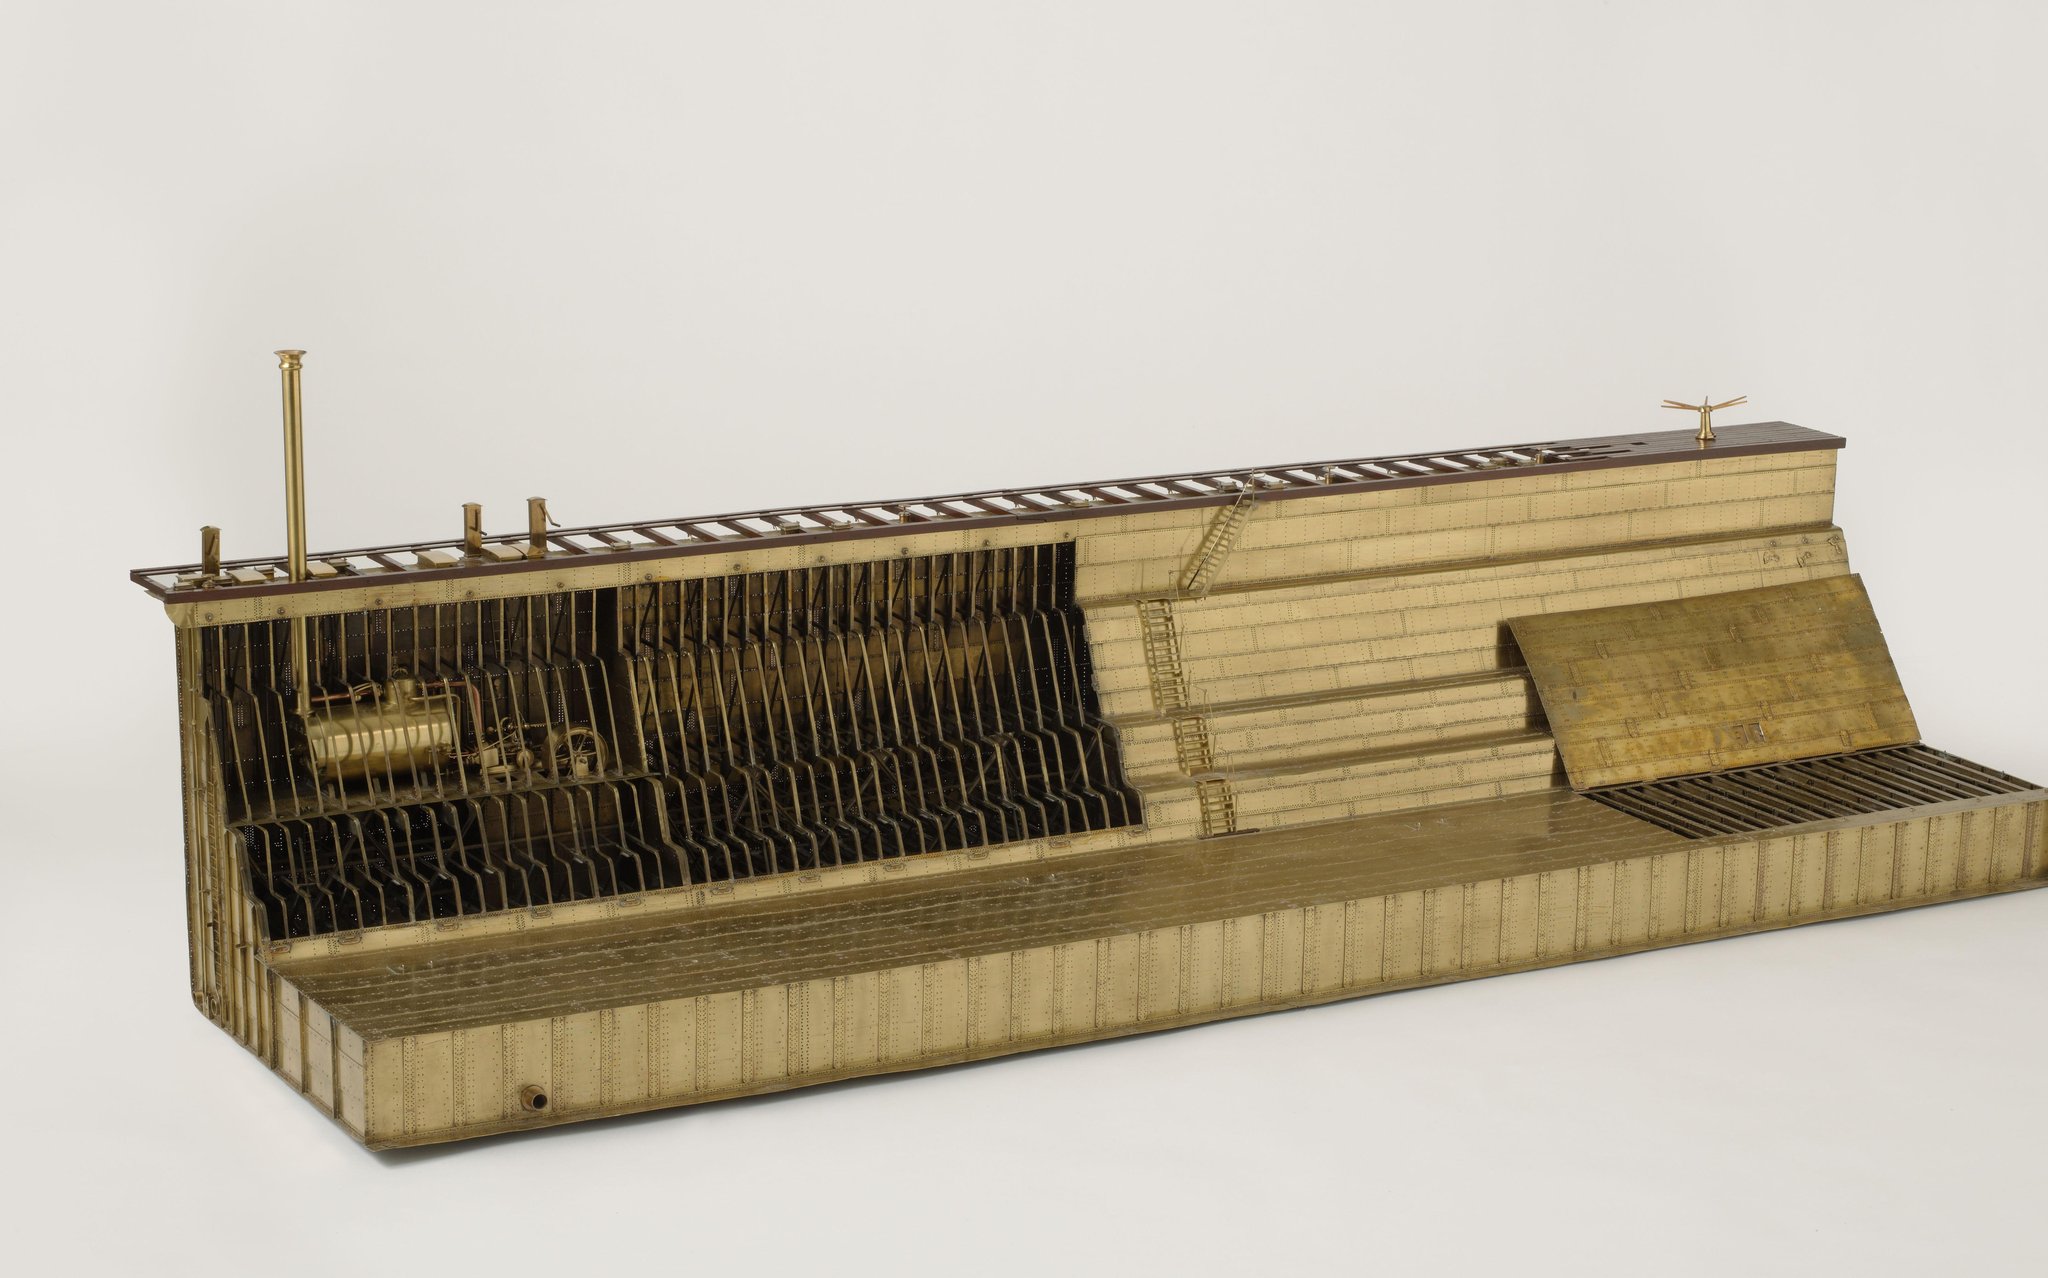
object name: demonstration model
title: Model of Part of a Floating Dry Dock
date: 1863-1864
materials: brass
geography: amsterdam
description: This model was exhibited at the Exposition Universelle of 1867–1868 in Paris. It represents a floating iron dry dock built in 1863–1864. The dock had been shipped in parts to Surabaya in Indonesia, whereit was assembled and towed to the island of Onrust. The dock comprised two halves. This model represents part of one half.